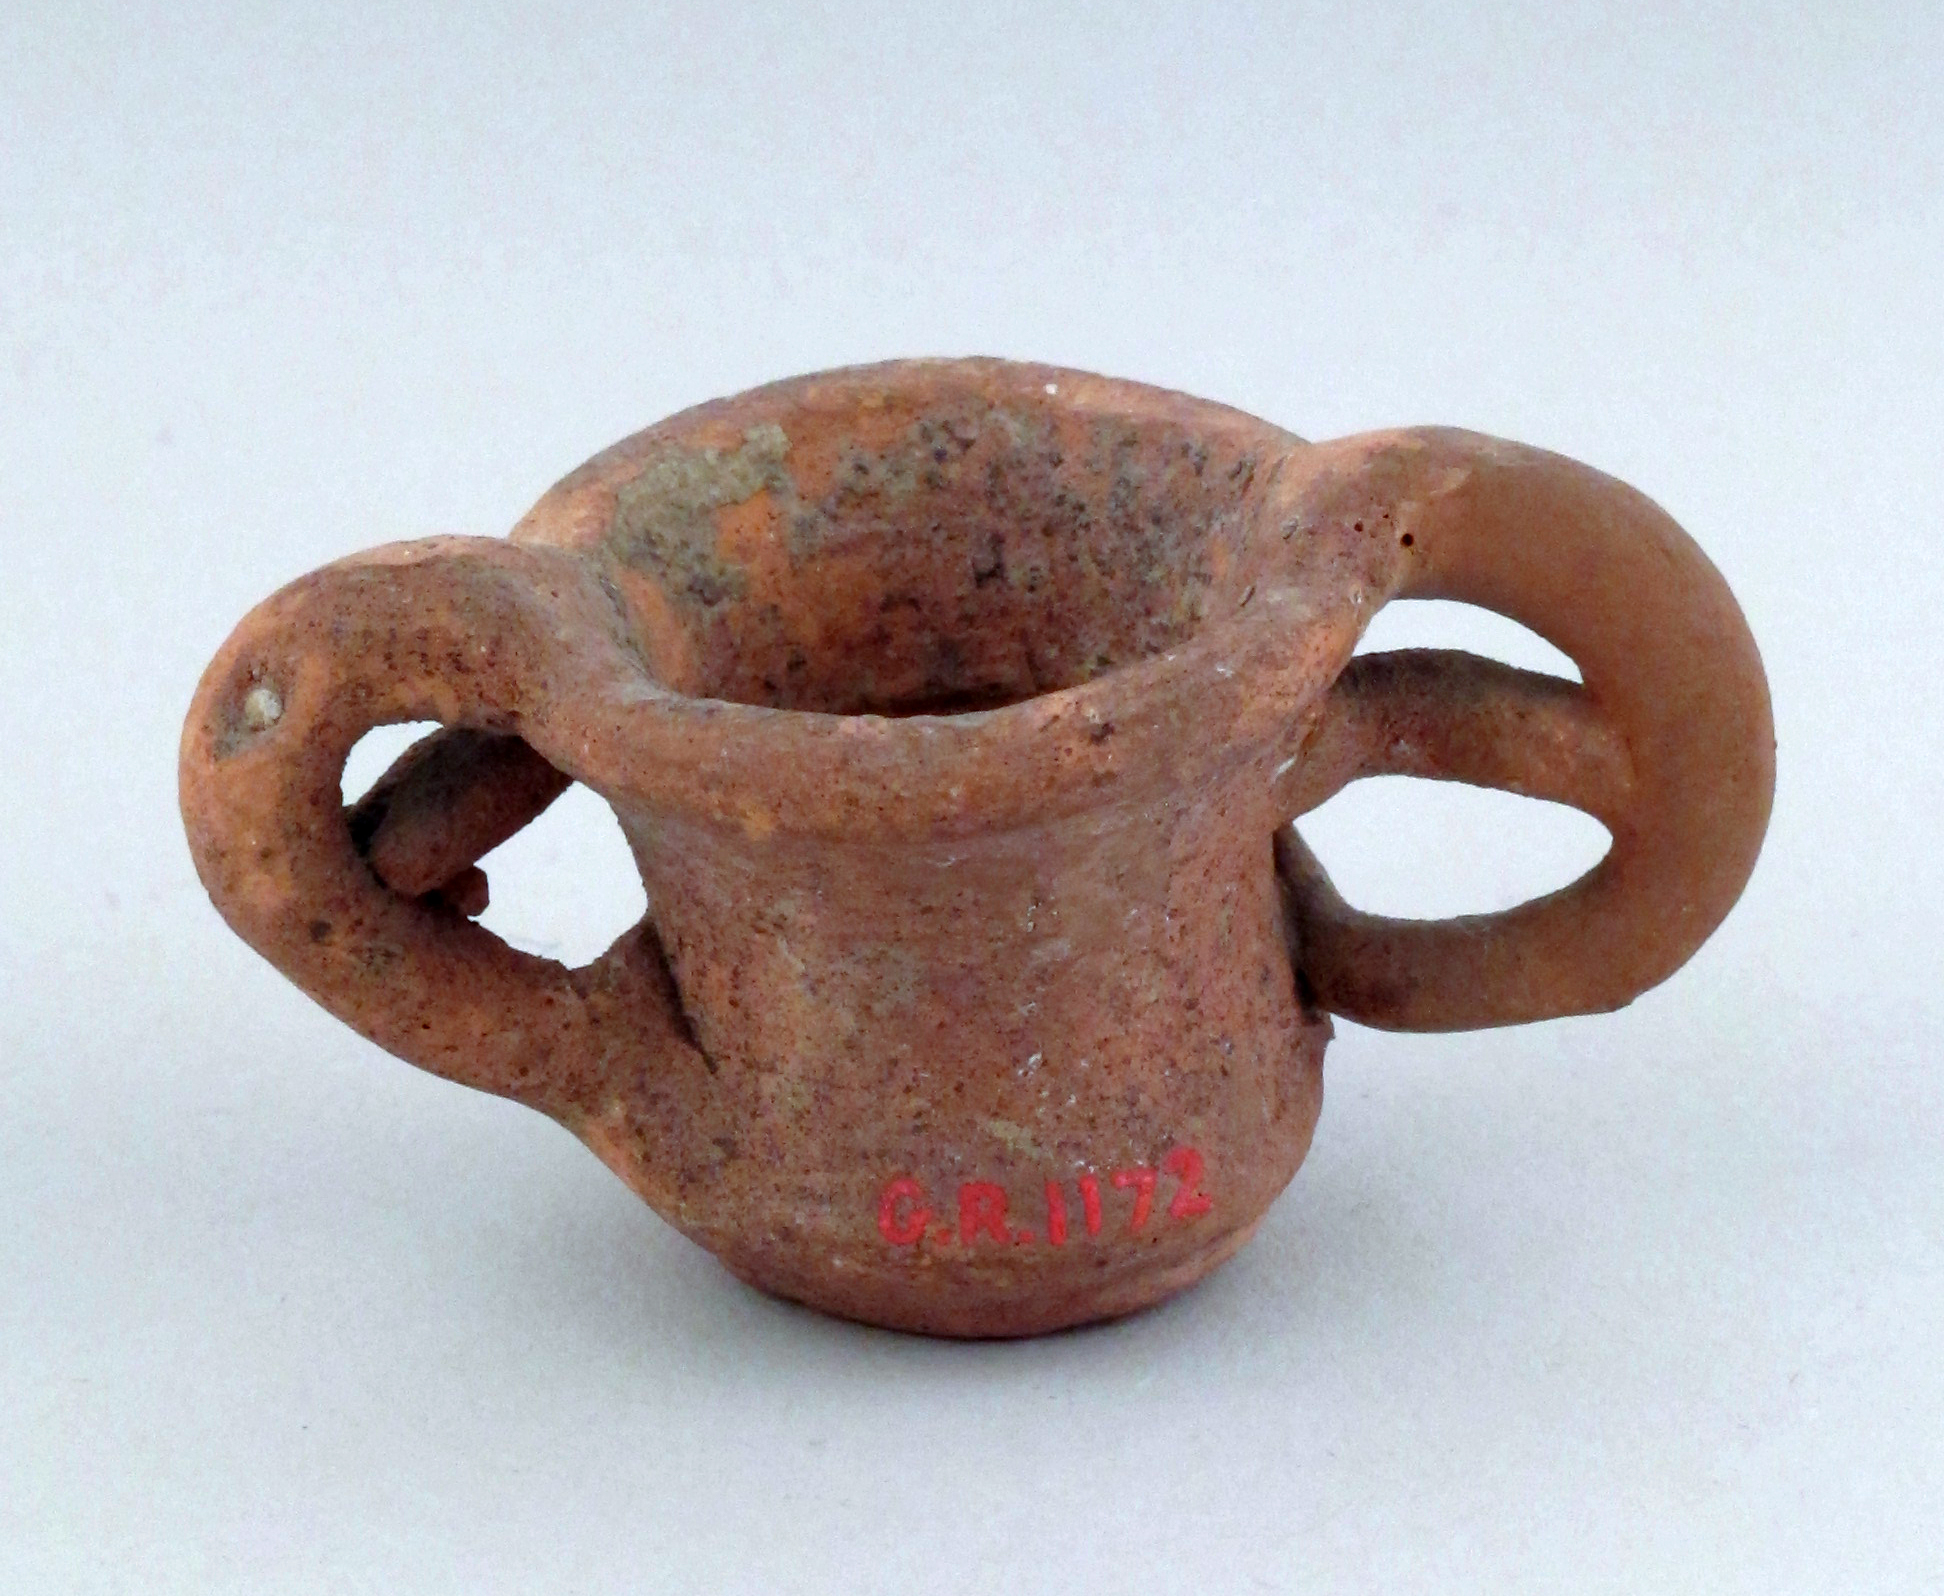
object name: cup, miniature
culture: etruscan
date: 500-101 BCE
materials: terracotta